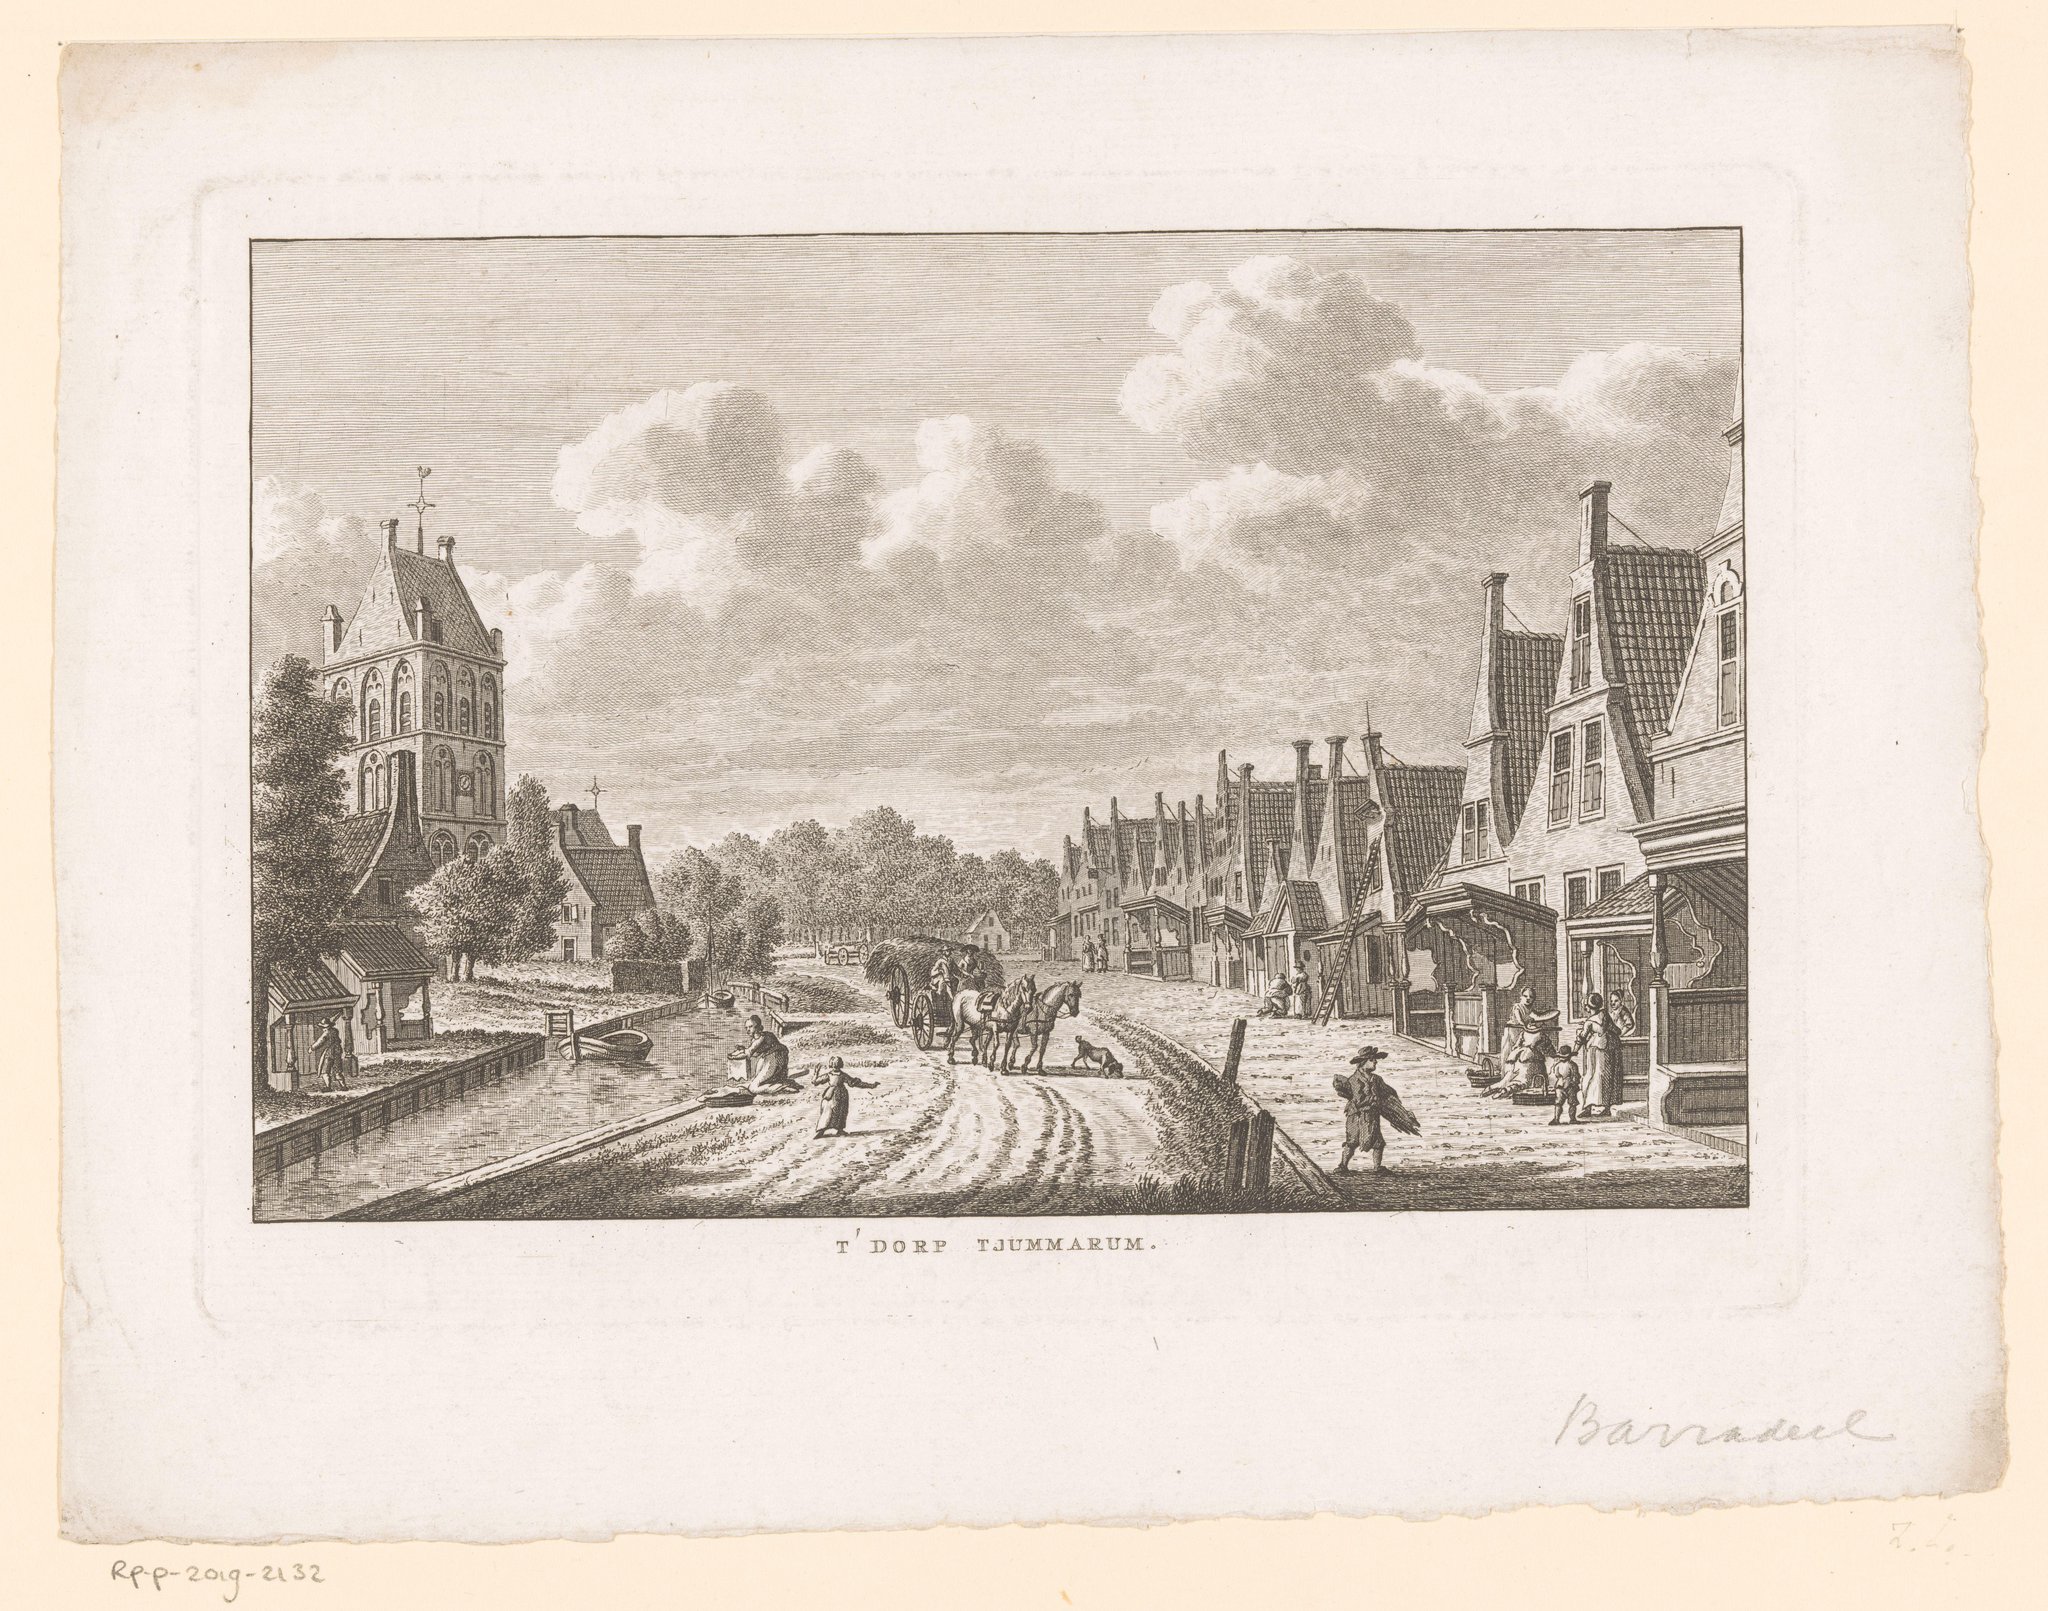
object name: print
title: T' dorp Tjummarum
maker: carel frederik bendorp (i)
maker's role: print maker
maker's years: 1736-1814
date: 1786-1792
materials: paper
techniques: etching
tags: village street, village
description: Prent uit: Vaderlandsche gezichten, of afbeeldingen van den tegenwoordigen staat der Vereenigde Nederlanden (…). Amsterdam: Hendrik Gartman, Willem Vermandel en Jan Willem Smit, 1786-1792. Uitgegeven in afleveringen met ieder een eigen bifolium en inhoudsopgave. Alle prenten in deze publicatie zijn gegraveerd door Carel Frederik Bendorp (I) en, in de meeste gevallen, gebaseerd op tekeningen van Jan Bulthuis.